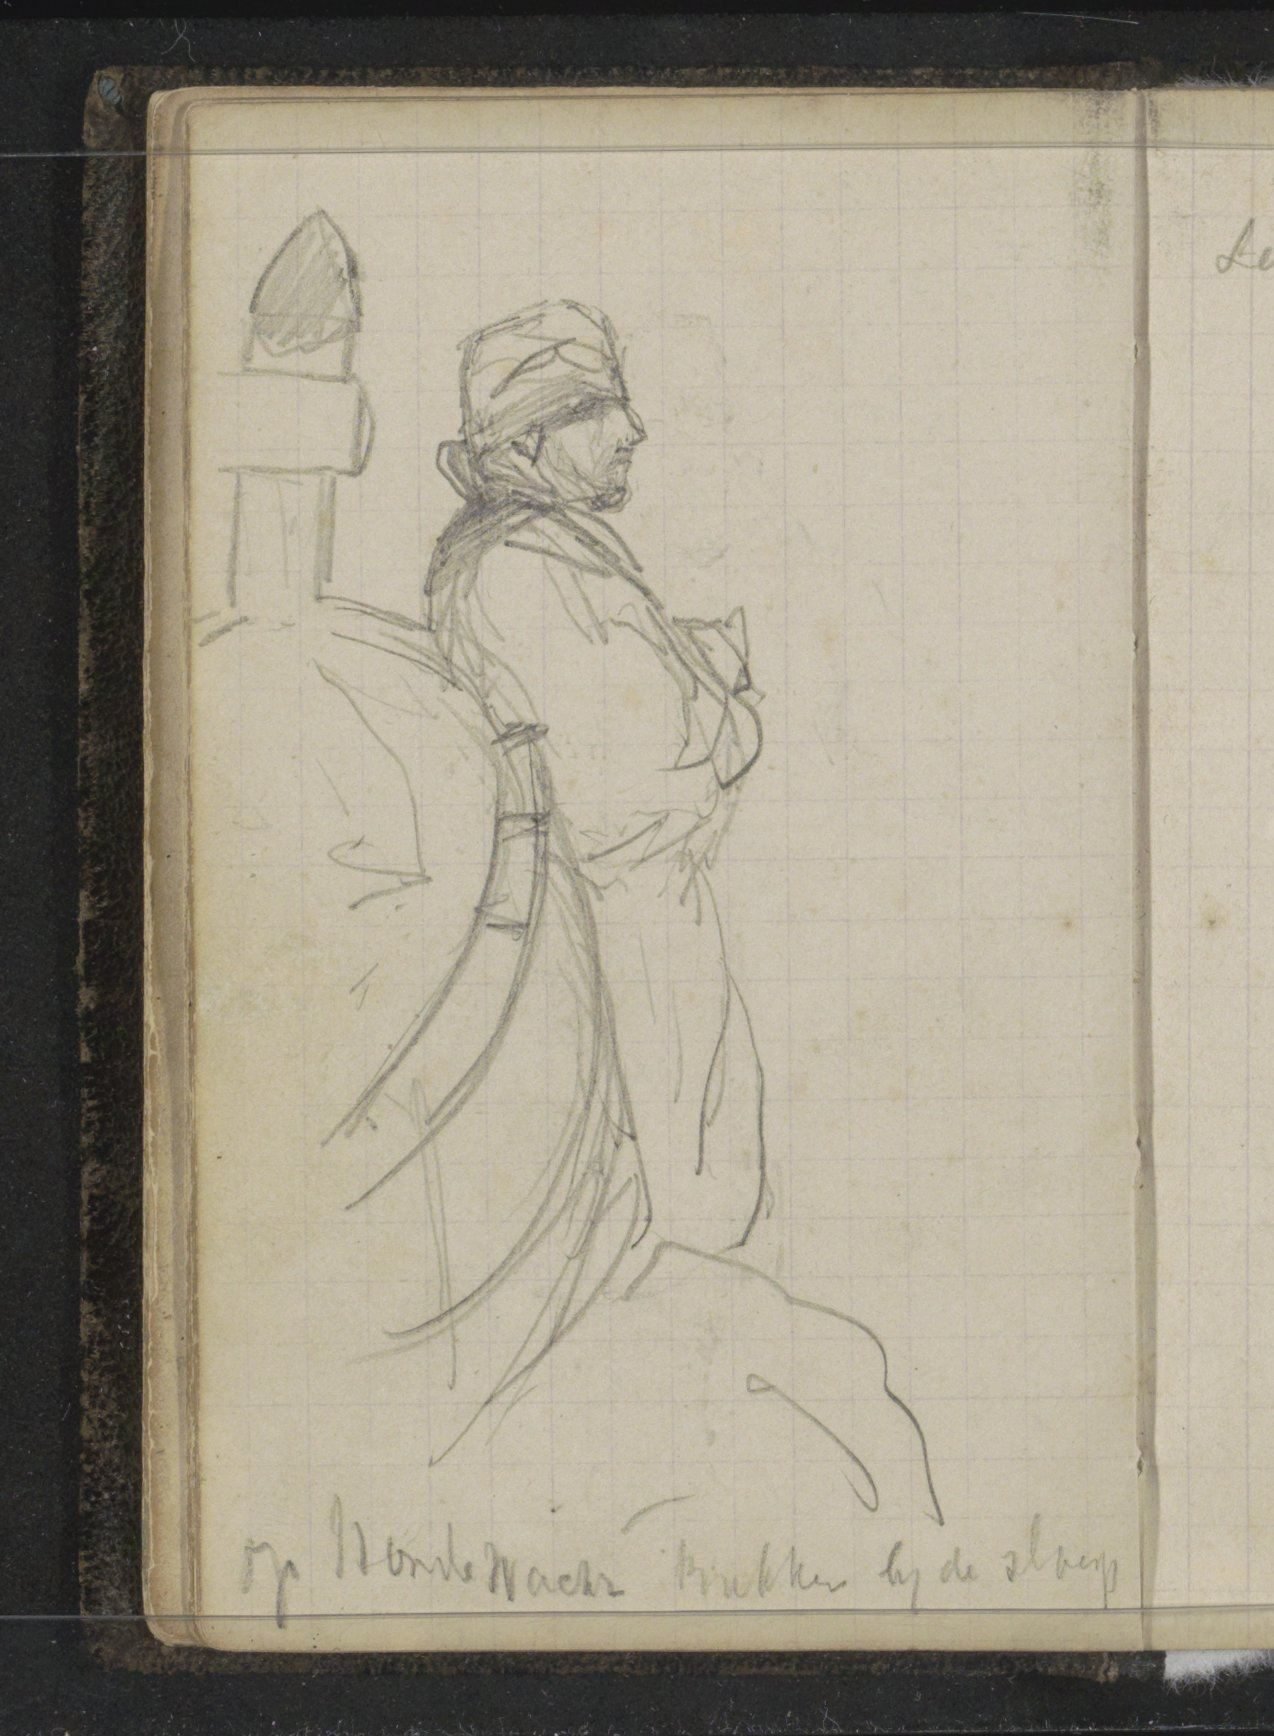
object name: sketchbook leaf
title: Bemanningslid leunt tegen een sloep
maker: louis apol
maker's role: draughtsman, painter, print maker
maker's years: 1850-1936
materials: pencil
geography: novaya zemlya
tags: rowing-boat, canoe, etc., adult man (+ leaning)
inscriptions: annotation: ‘op hondewacht Brikker bij de sloep’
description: Mogelijk Brikker genaamd. Hij staat op hondenwacht. Blad 17 verso uit een schetsboek met 110 bladen betekend tijdens de expeditie naar Nova Zembla in 1880.